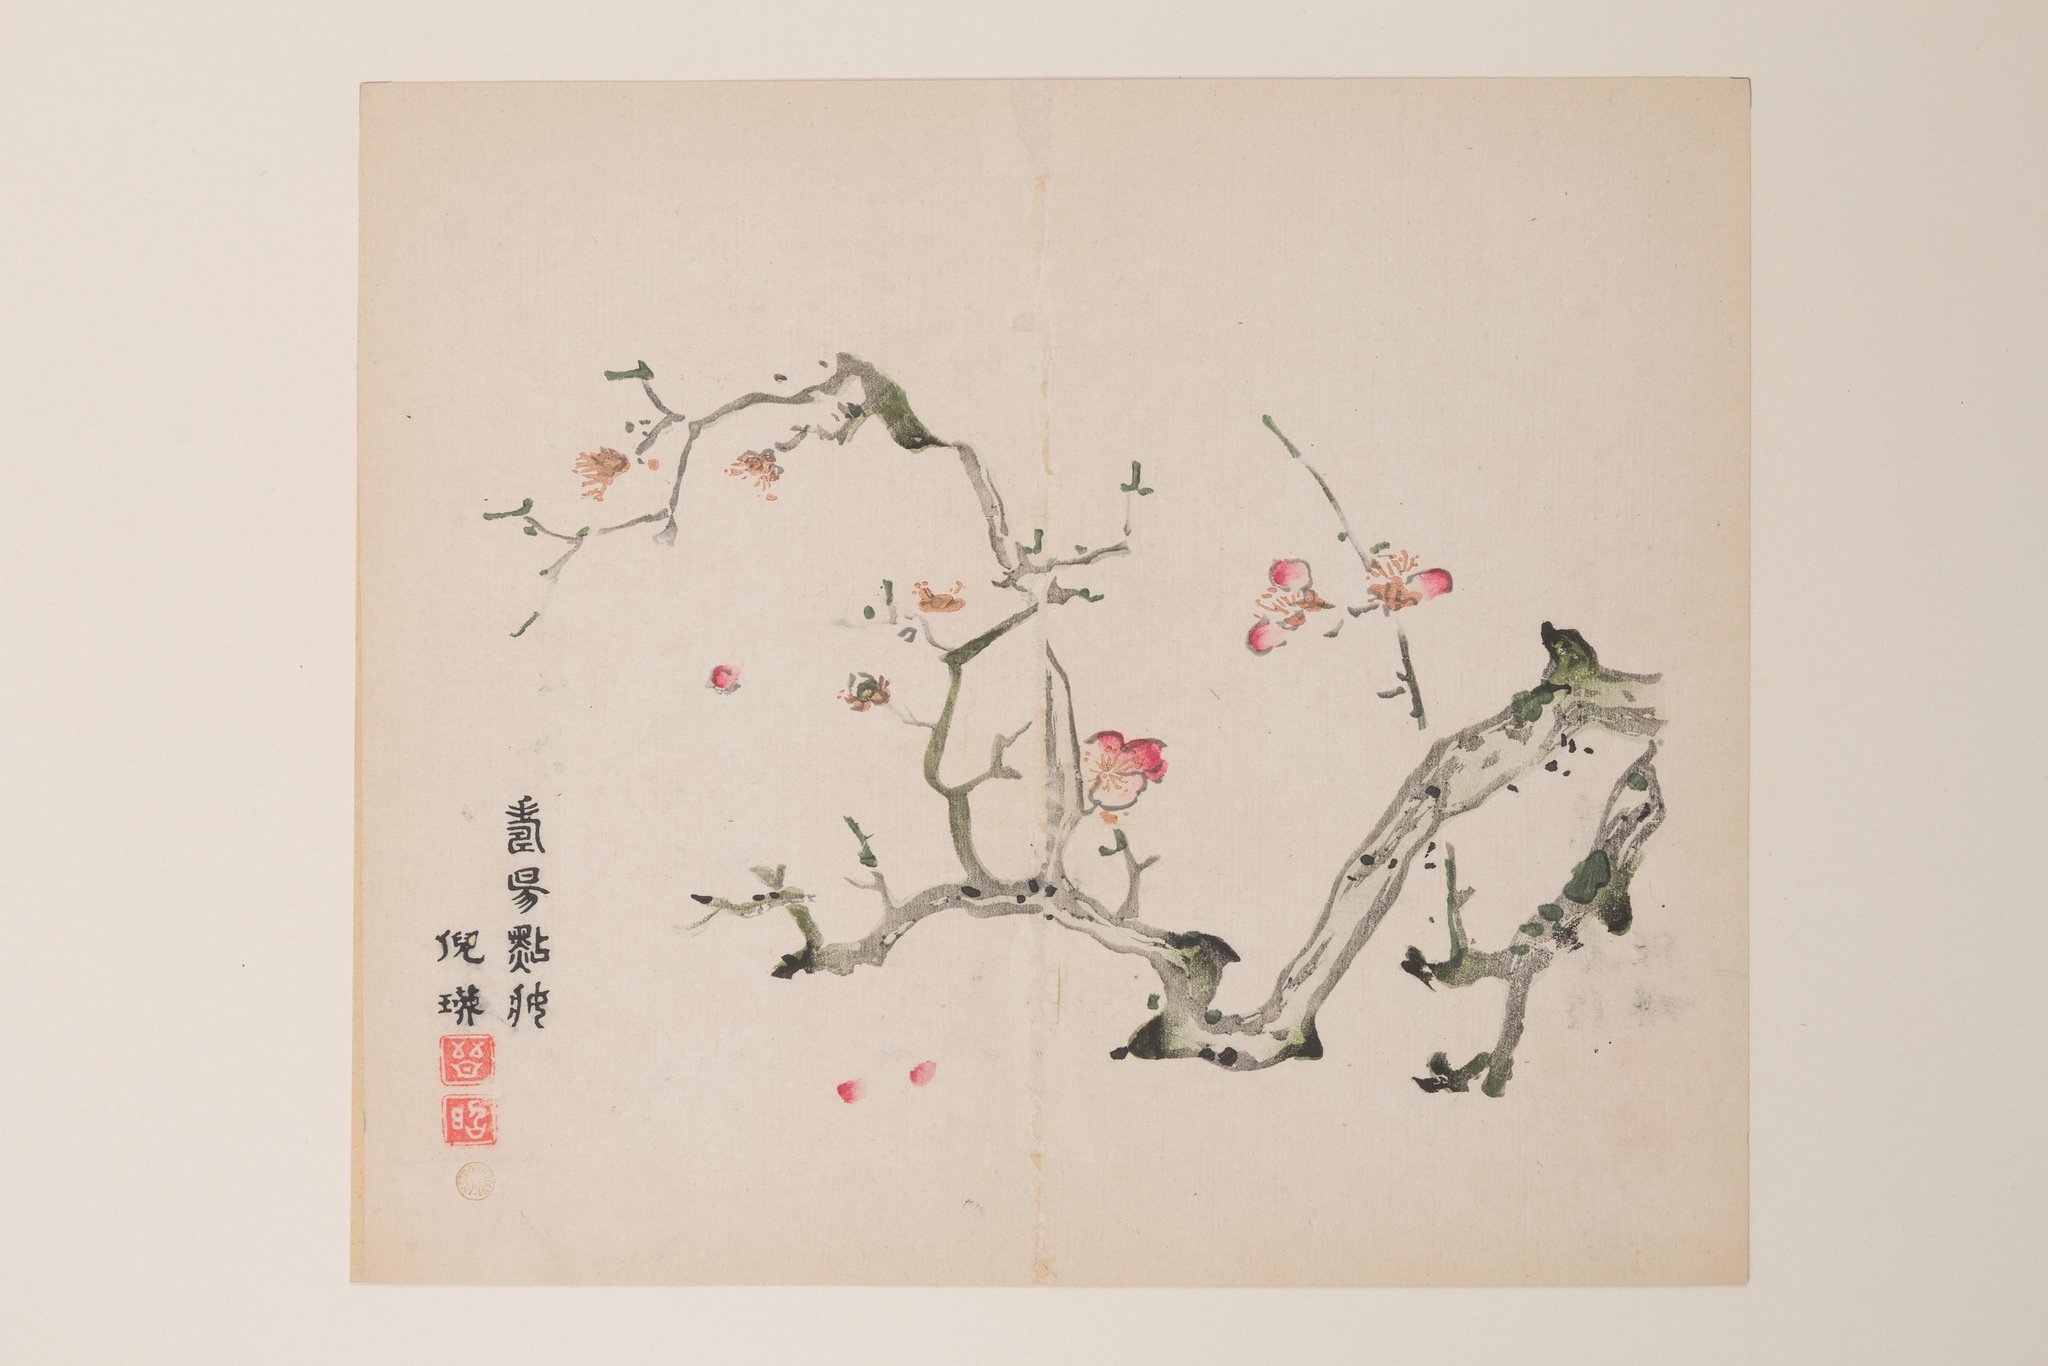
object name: print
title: Page from Shi Zhu Zhai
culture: chinese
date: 1662-1722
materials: ink, paper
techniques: polychrome, woodblock print